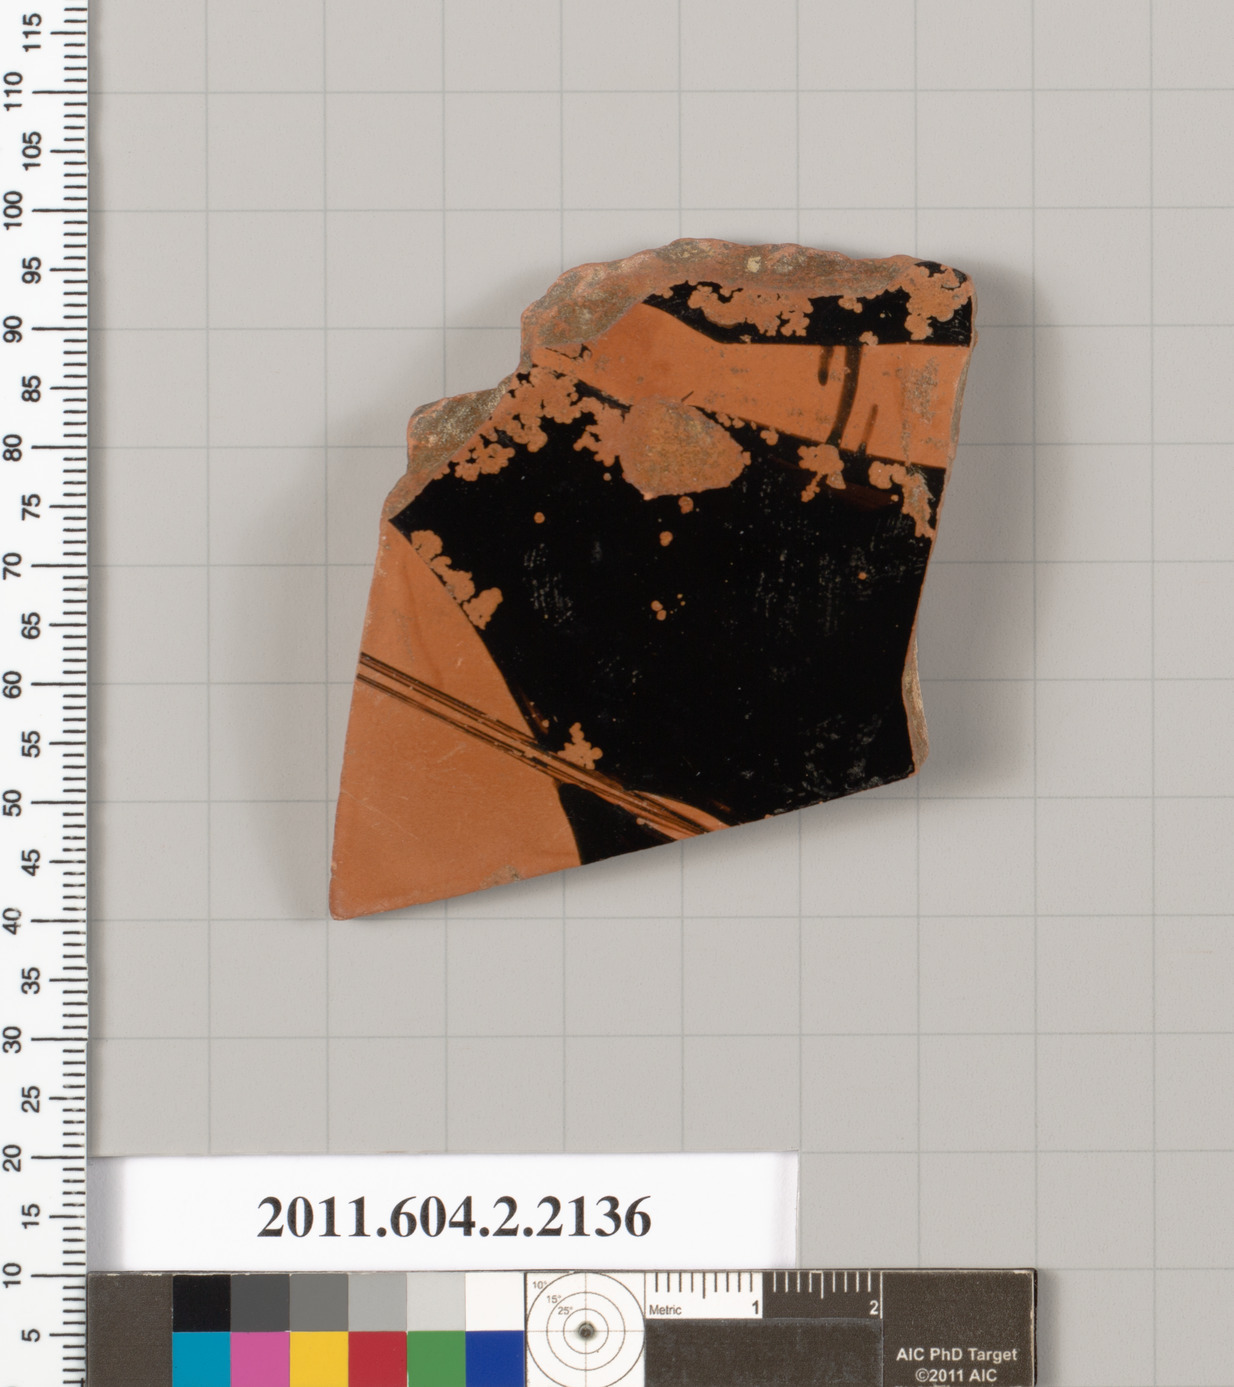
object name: pot fragment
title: Terracotta fragment of a pot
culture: greek, attic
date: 475-451 BCE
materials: terracotta